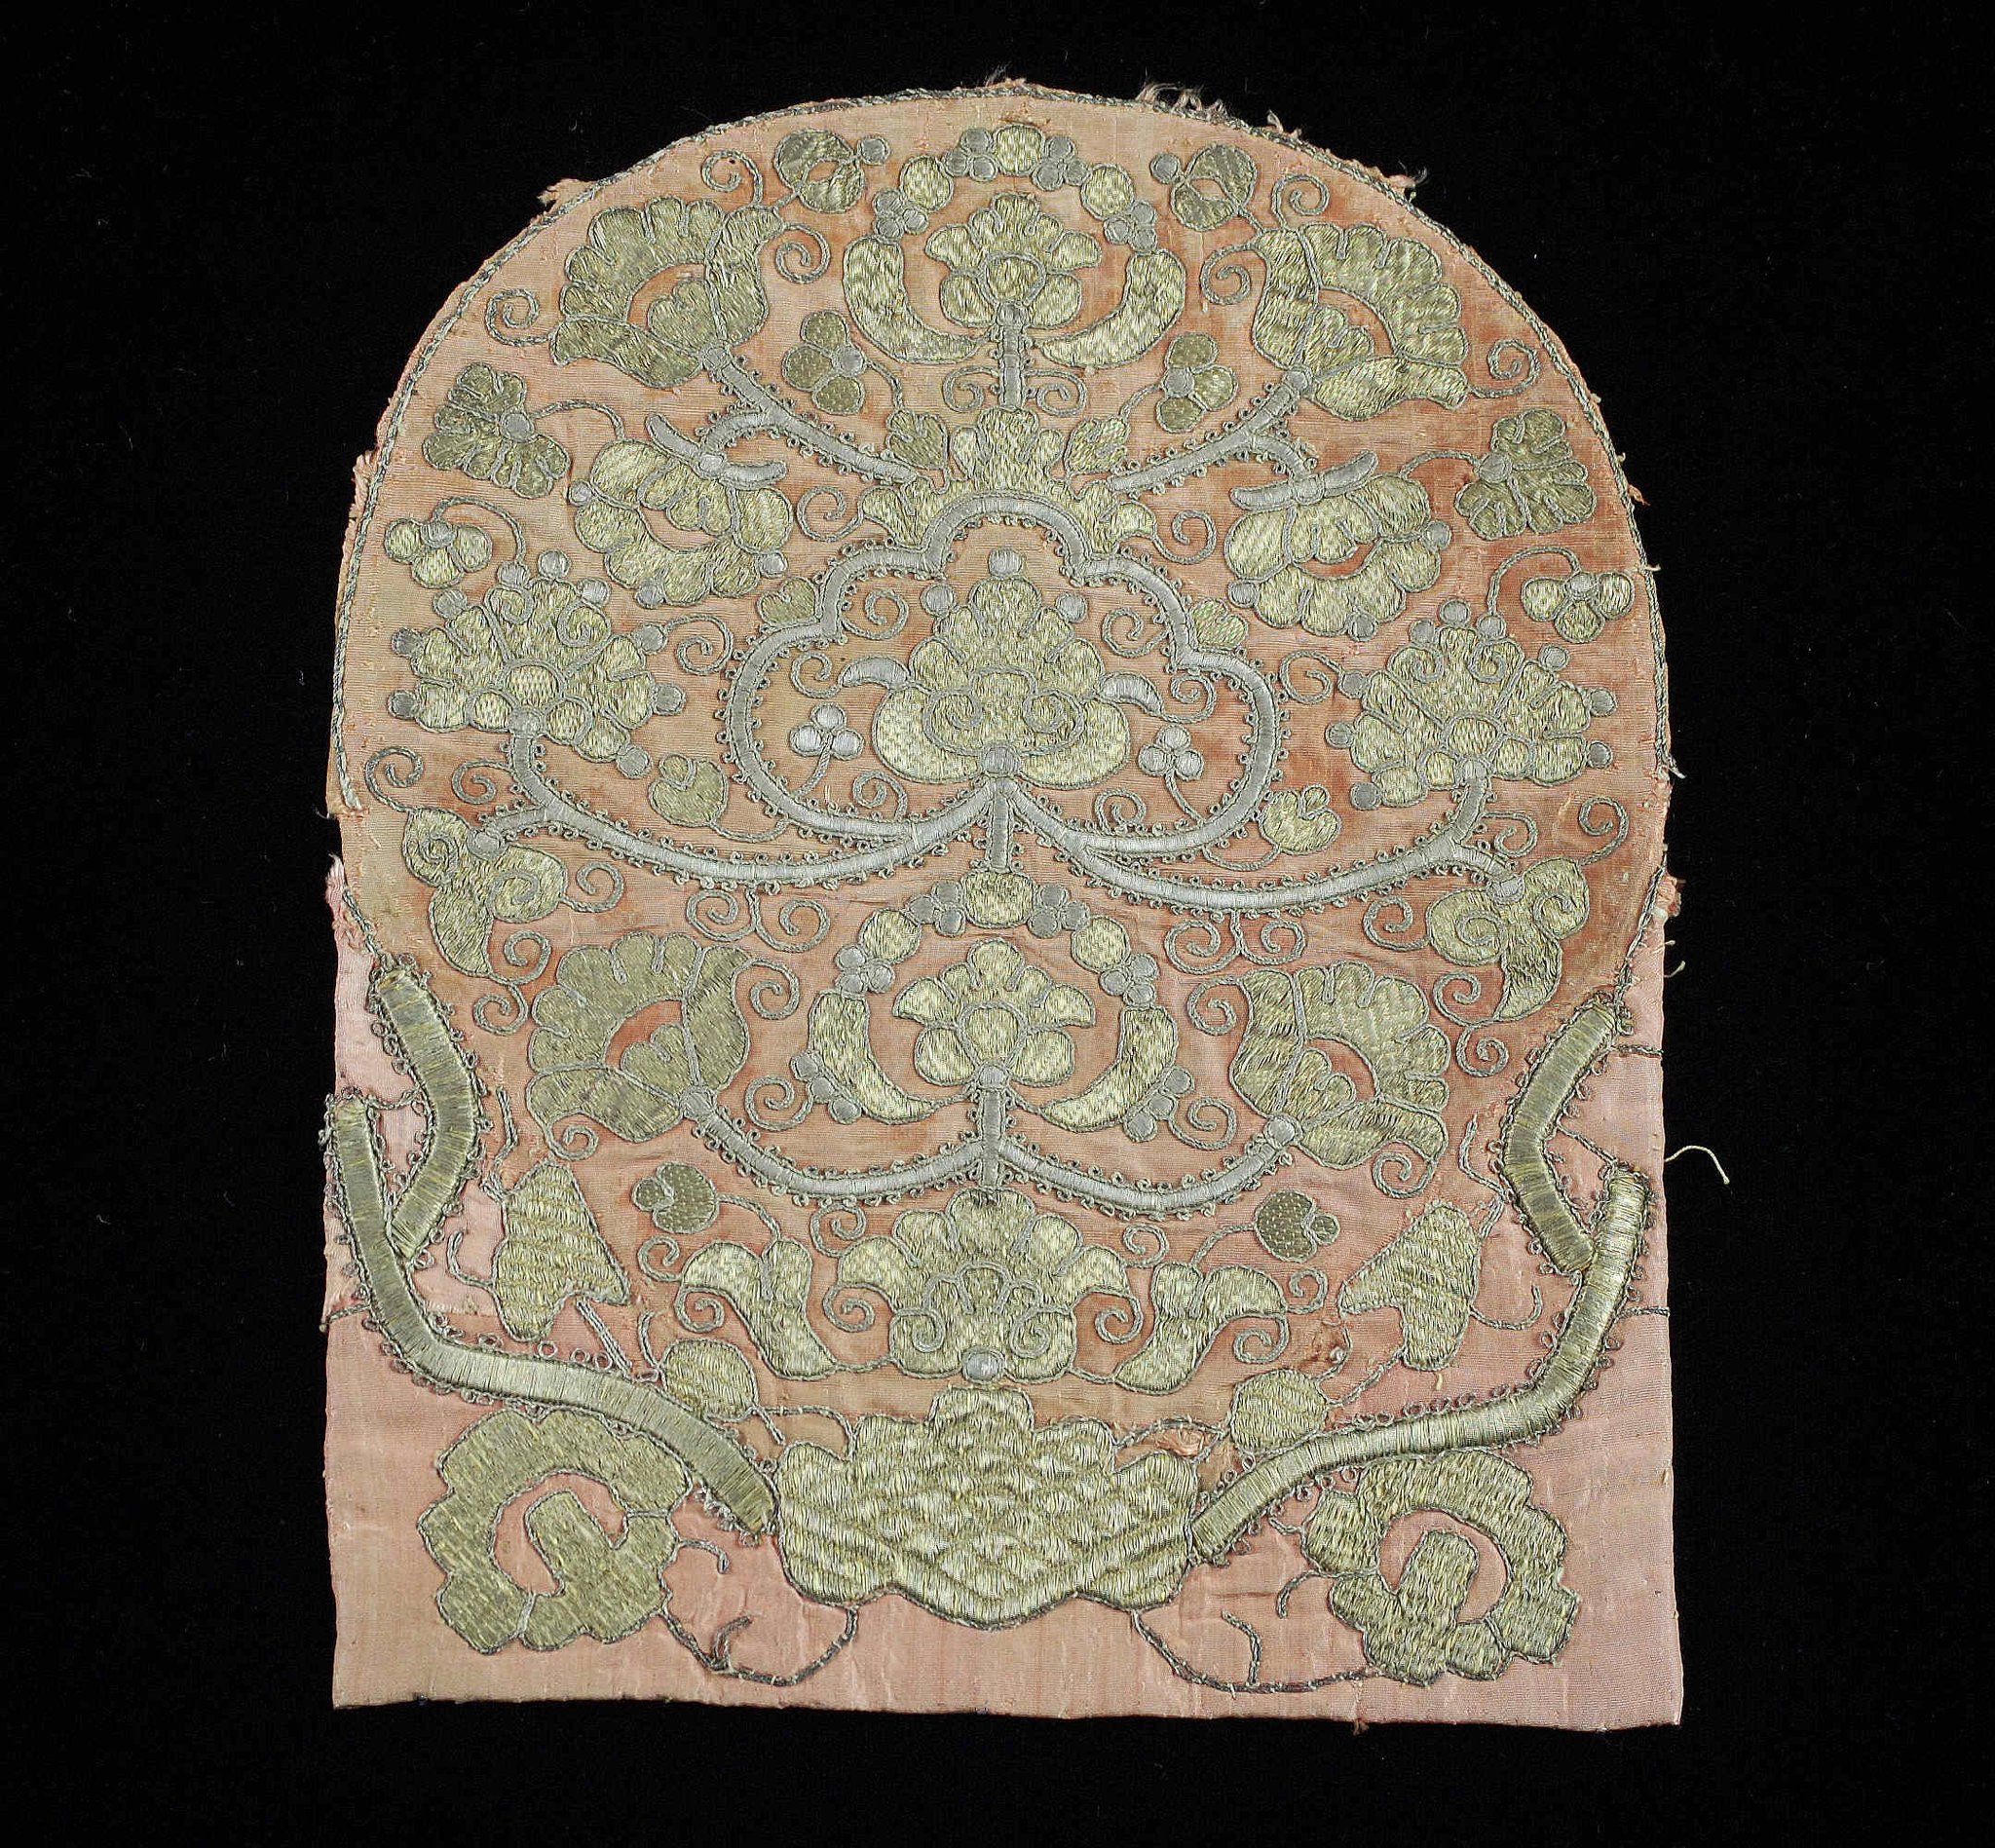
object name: headdress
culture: russian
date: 1776-1800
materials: linen, silk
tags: flowers